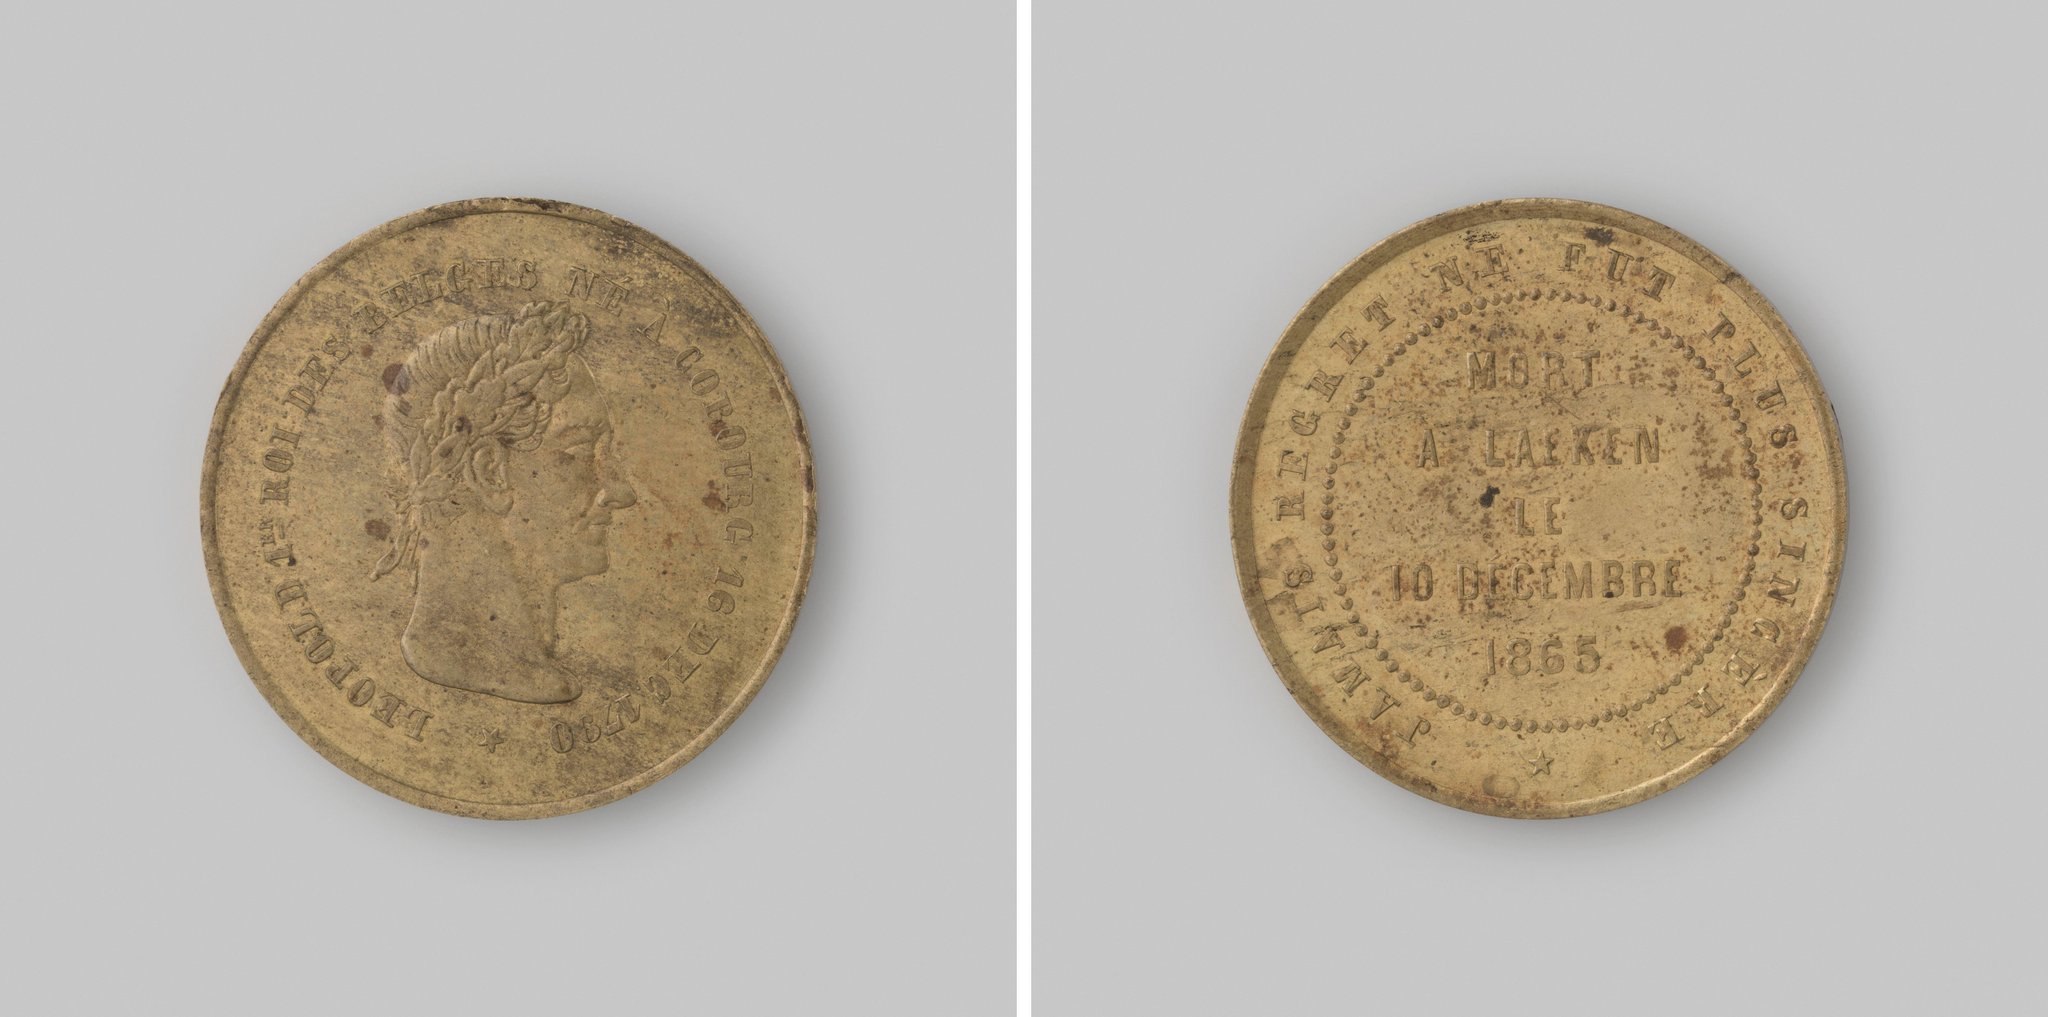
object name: history medal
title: Overlijden van Koning Leopold I van België 1865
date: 1865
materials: brass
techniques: striking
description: Messing penning, op de voorzijde het portret van Leopold naar rechts met omschrift, op de keerzijde vijf regels tekst met omschrift.